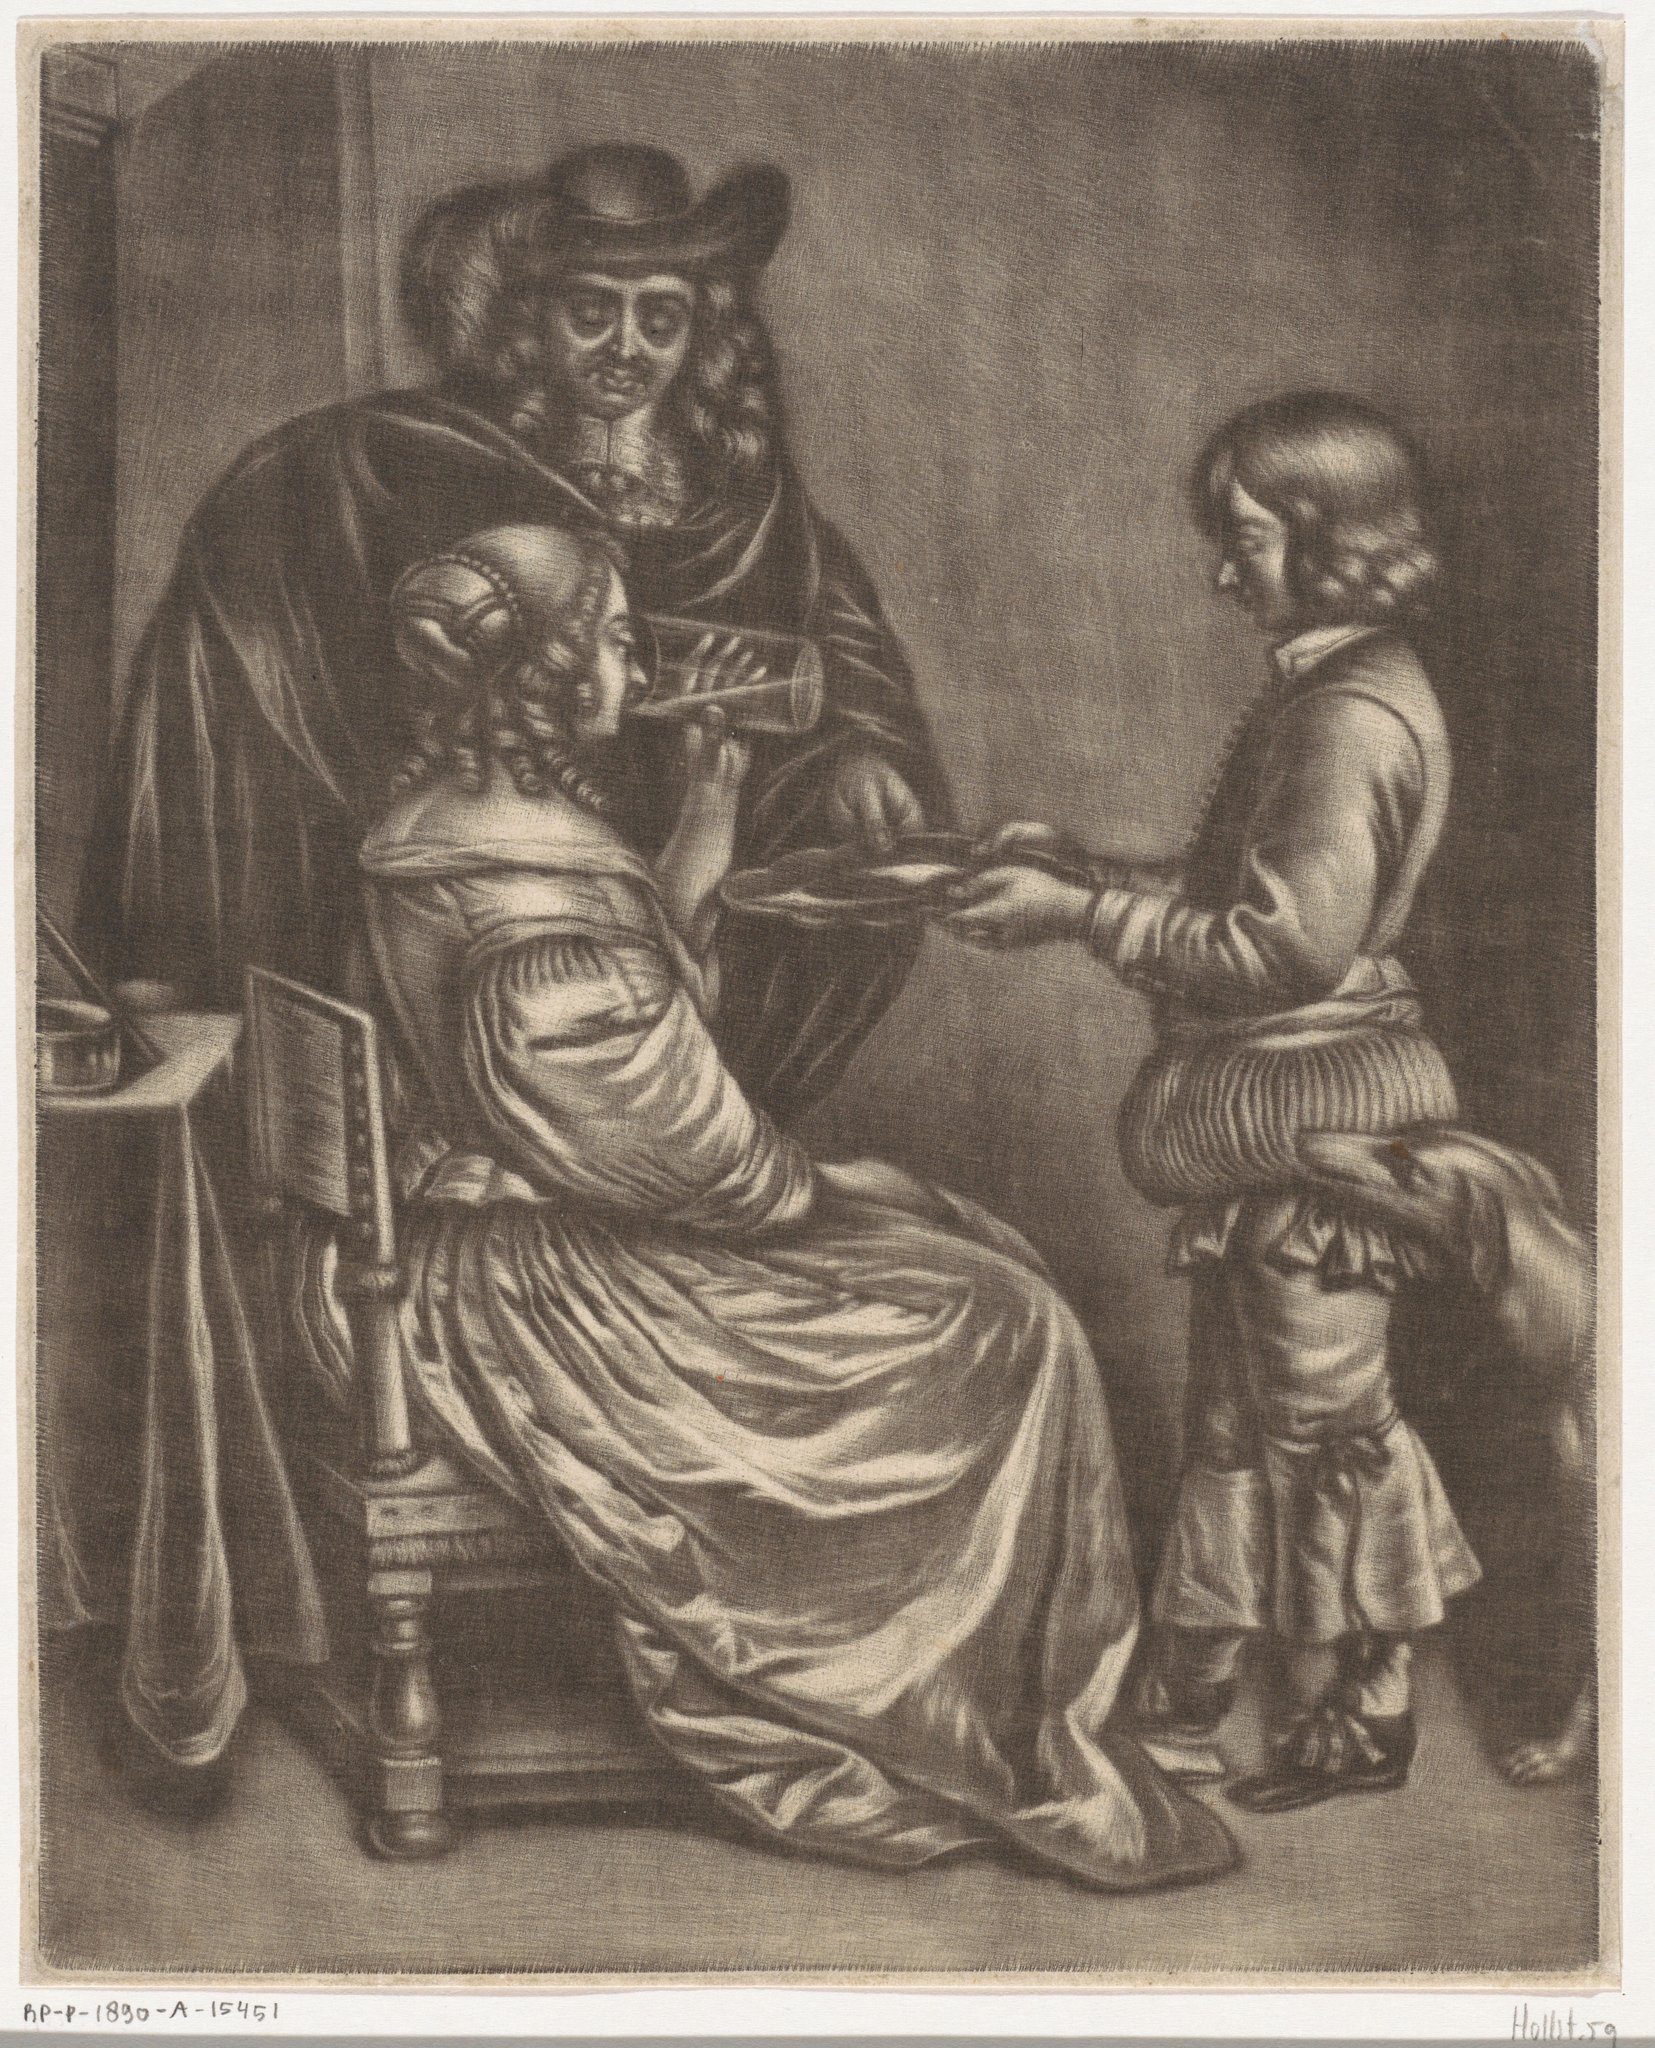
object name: print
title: Drinkende dame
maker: jan van somer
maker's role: draughtsman, print maker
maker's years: 1645-1699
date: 1676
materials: paper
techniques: mezzotint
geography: amsterdam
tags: drinking, dog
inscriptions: collector's mark: Lugt 2228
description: Zittend in een stoel drinkt een vrouw uit een glas. Voor haar staat een dienstbode die samen met een man een dienblad voor haar ophoudt.